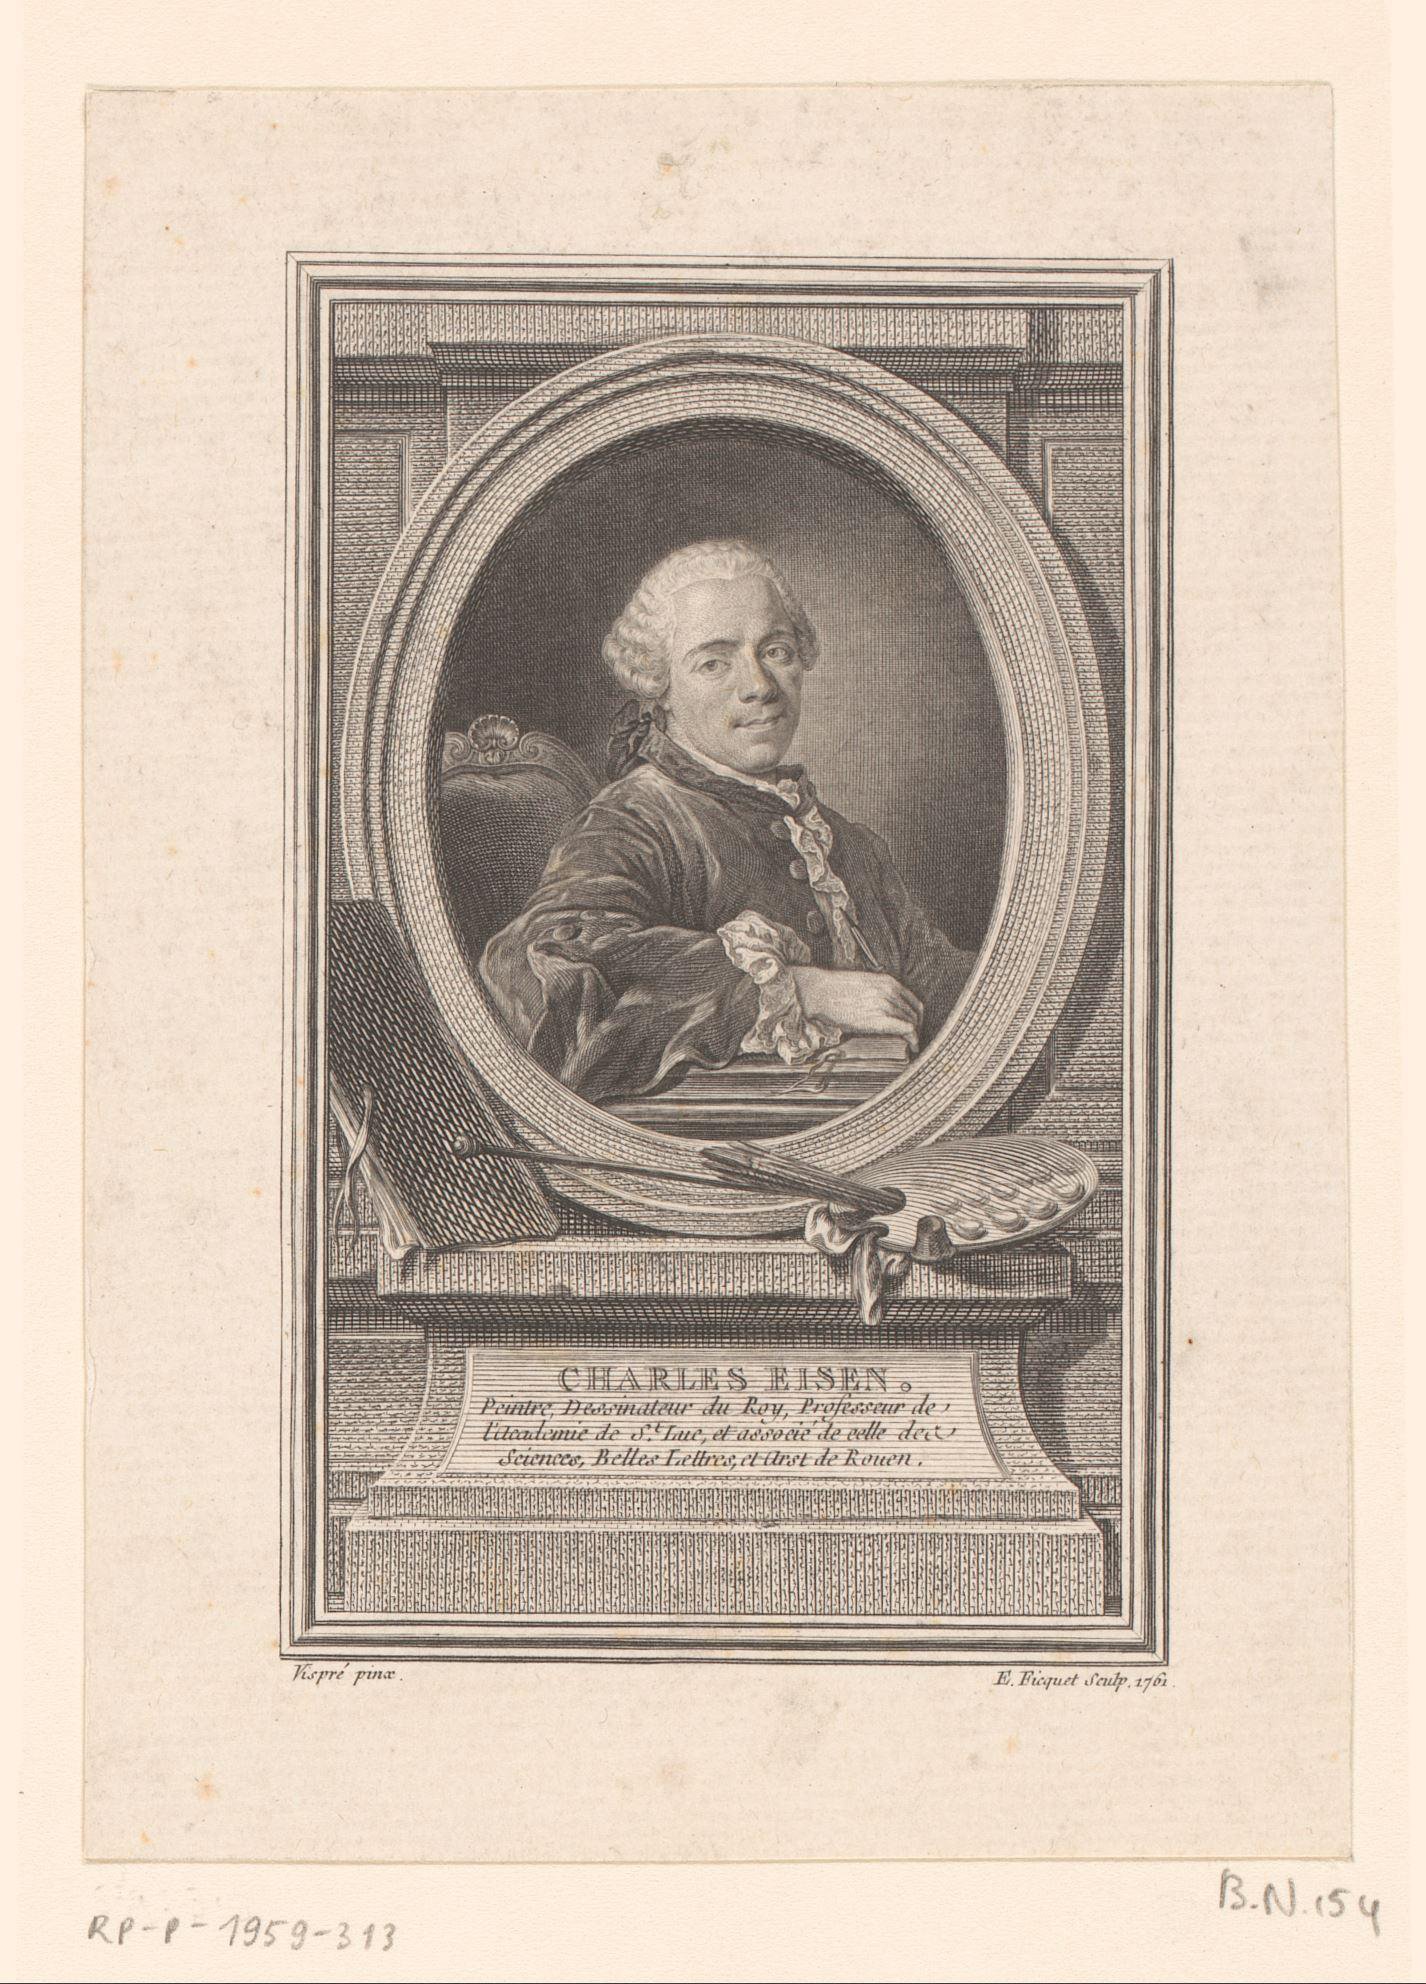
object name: print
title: Portret van Charles-Dominique-Joseph Eisen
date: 1761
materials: paper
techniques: engraving, etching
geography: france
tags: brussels, draughtsman, charles joseph dominique eisen, historical persons, portrait, self-portrait of painter, palette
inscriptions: collector's mark: Lugt 2760, collector's mark: Lugt 2228